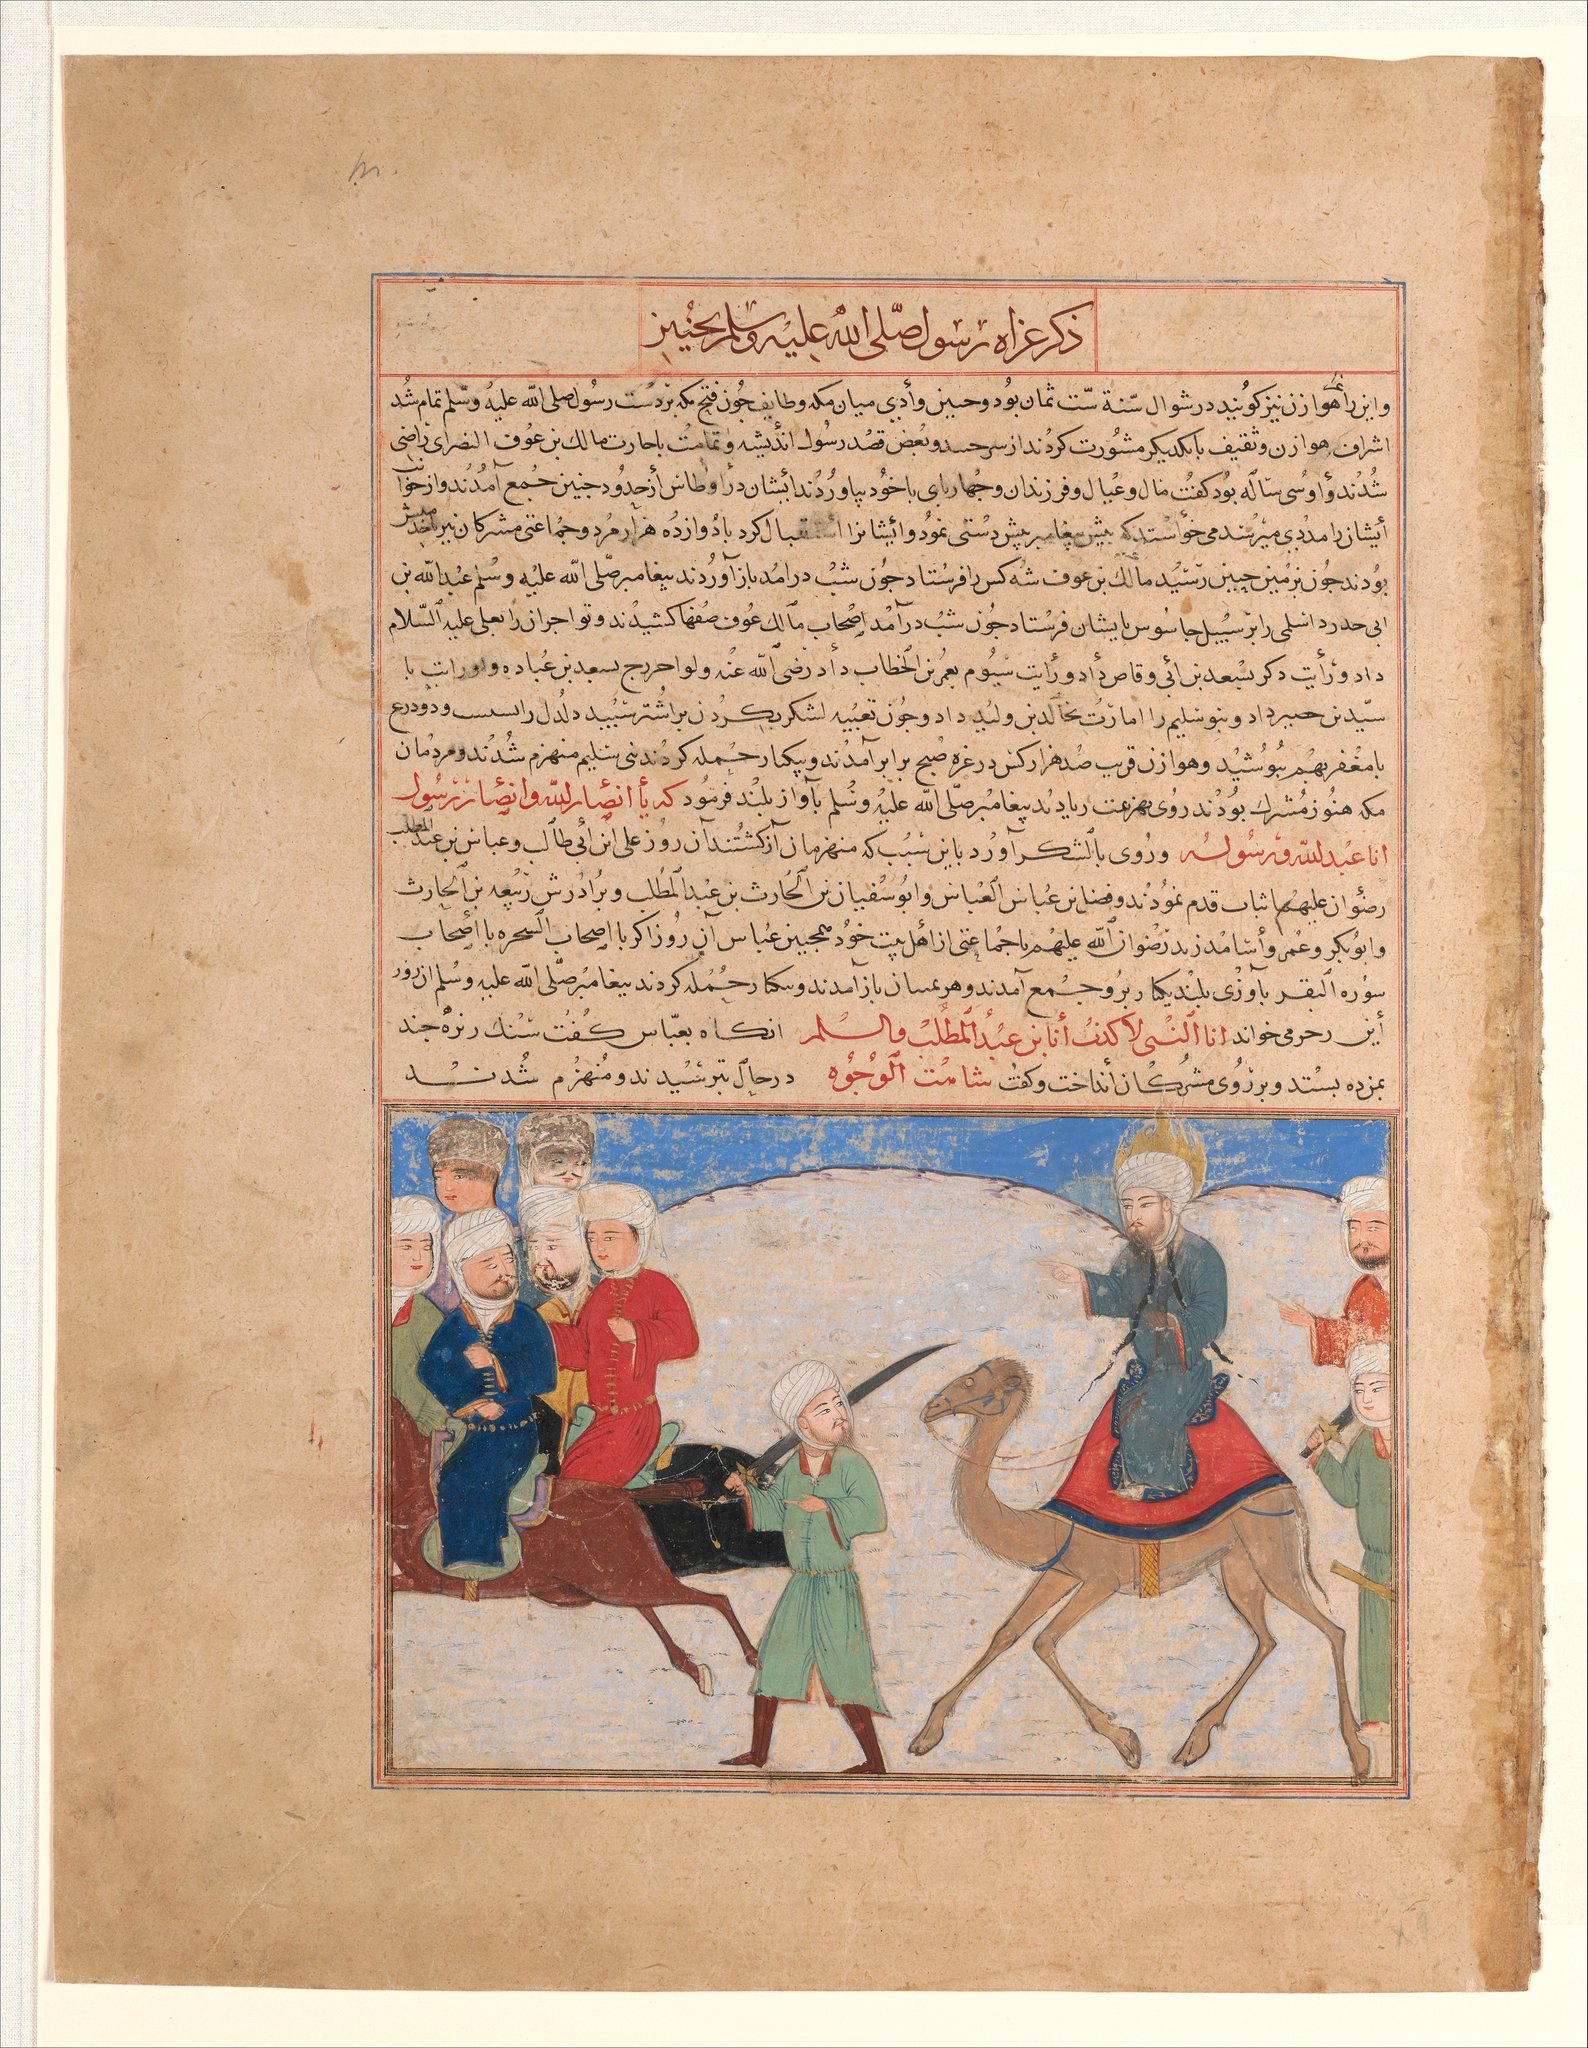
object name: folio from an illustrated manuscript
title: "Journey of the Prophet Muhammad", Folio from the Majma al-Tavarikh (Compendium of Histories)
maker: hafiz-i abru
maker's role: author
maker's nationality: iranian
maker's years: 1350-1430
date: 1425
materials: gold, ink, paper, watercolor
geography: afghanistan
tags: men,camels